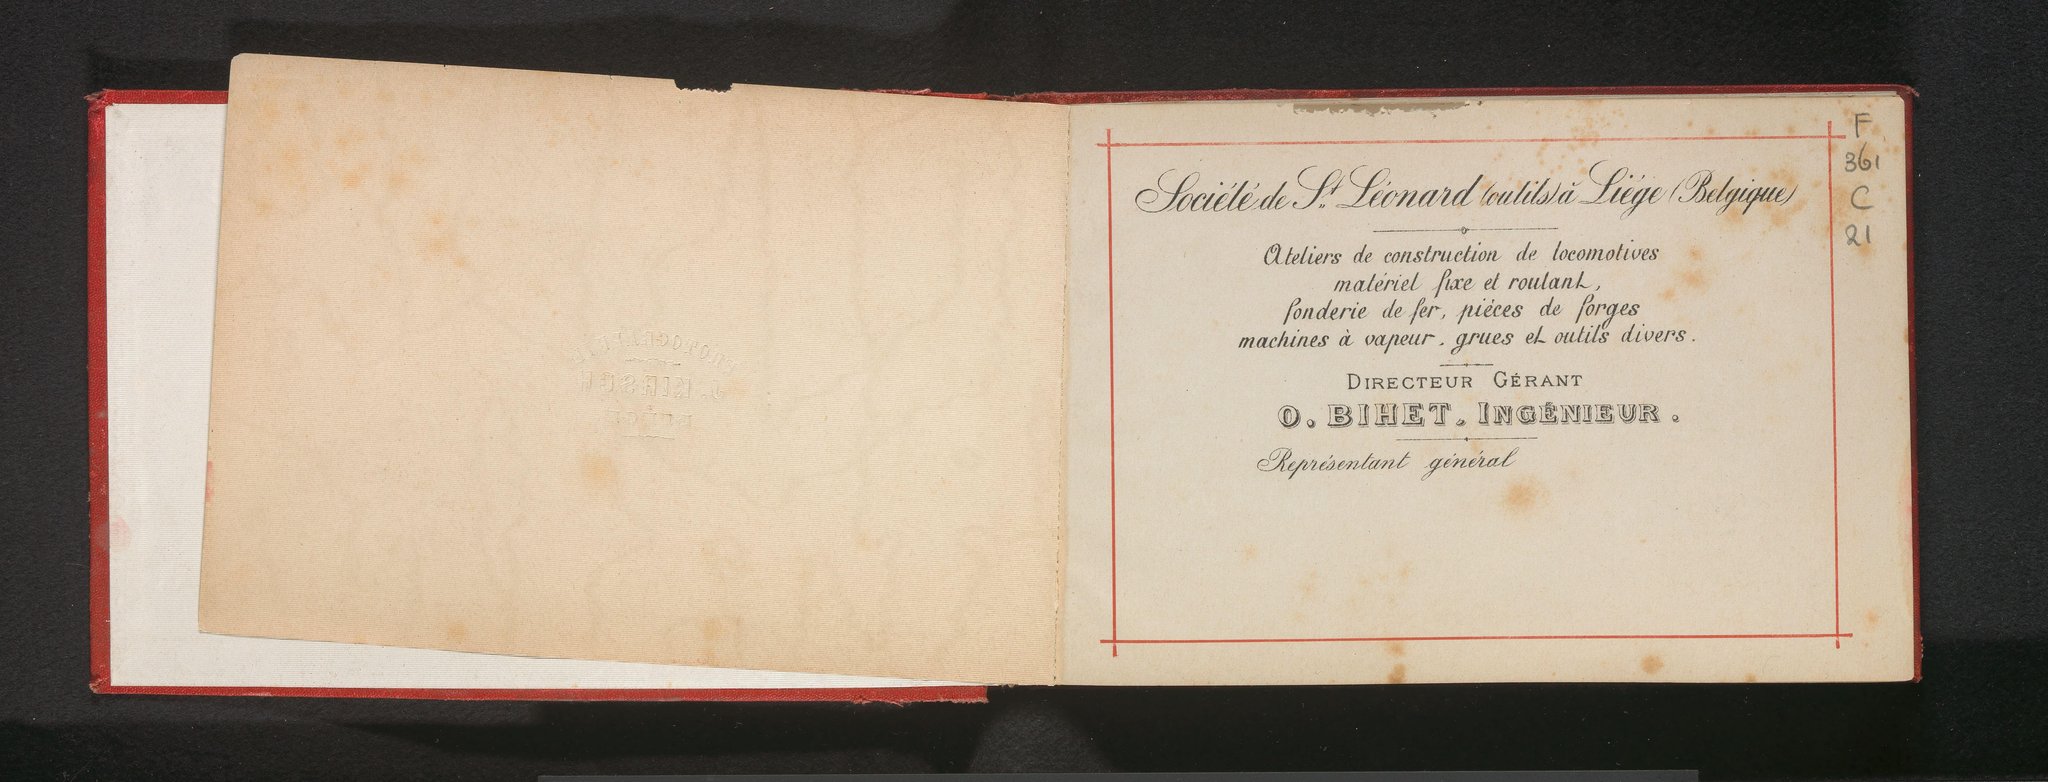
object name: book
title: Société de St. Léonard (outils) à Liége (Belgique) : ateliers de construction de locomotives, matériel fixe et roulant, fonderie de fer, pièces de forges, machines à vapeur, grues et outils divers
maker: Anonymous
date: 1885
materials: cardboard, paper, textile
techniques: albumen print, printing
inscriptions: workshop stamp: ‘Photographie/ J. Kirsch/ Liége’